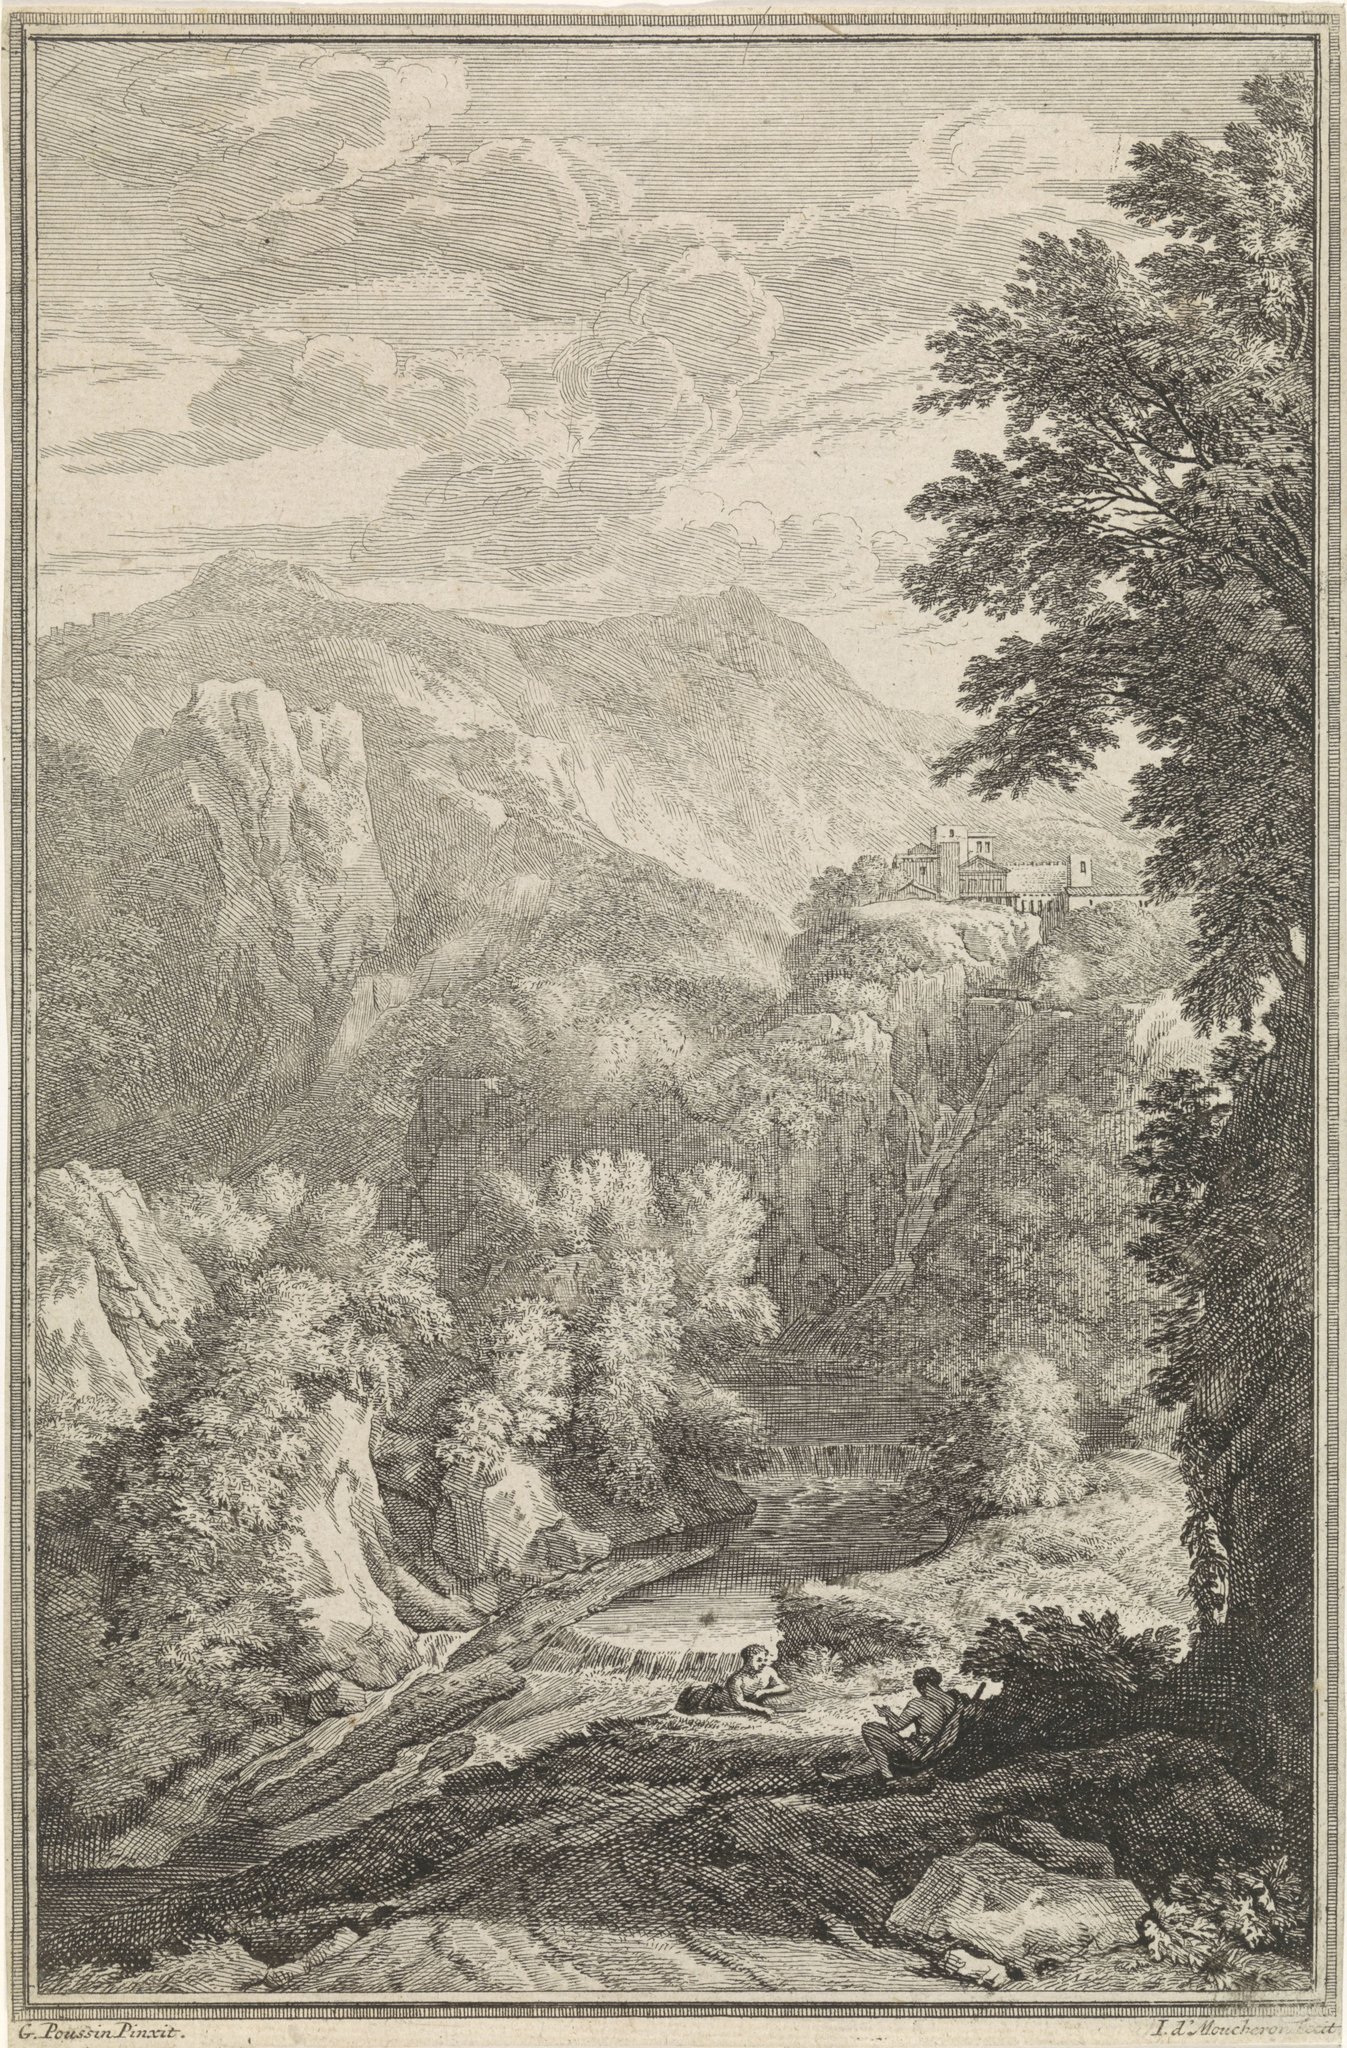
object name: print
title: Arcadisch landschap met bergen en een rivier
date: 1697-1744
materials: paper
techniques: engraving, etching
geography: amsterdam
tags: river, waterfall, pastorals, arcadian scenes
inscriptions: collector's mark: Lugt 2228, collector's mark: Lugt 2760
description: Arcadisch landschap met kleine watervallen in een rivier. Op de voorgrond twee figuren. op de achtergrond bergen en een stad.